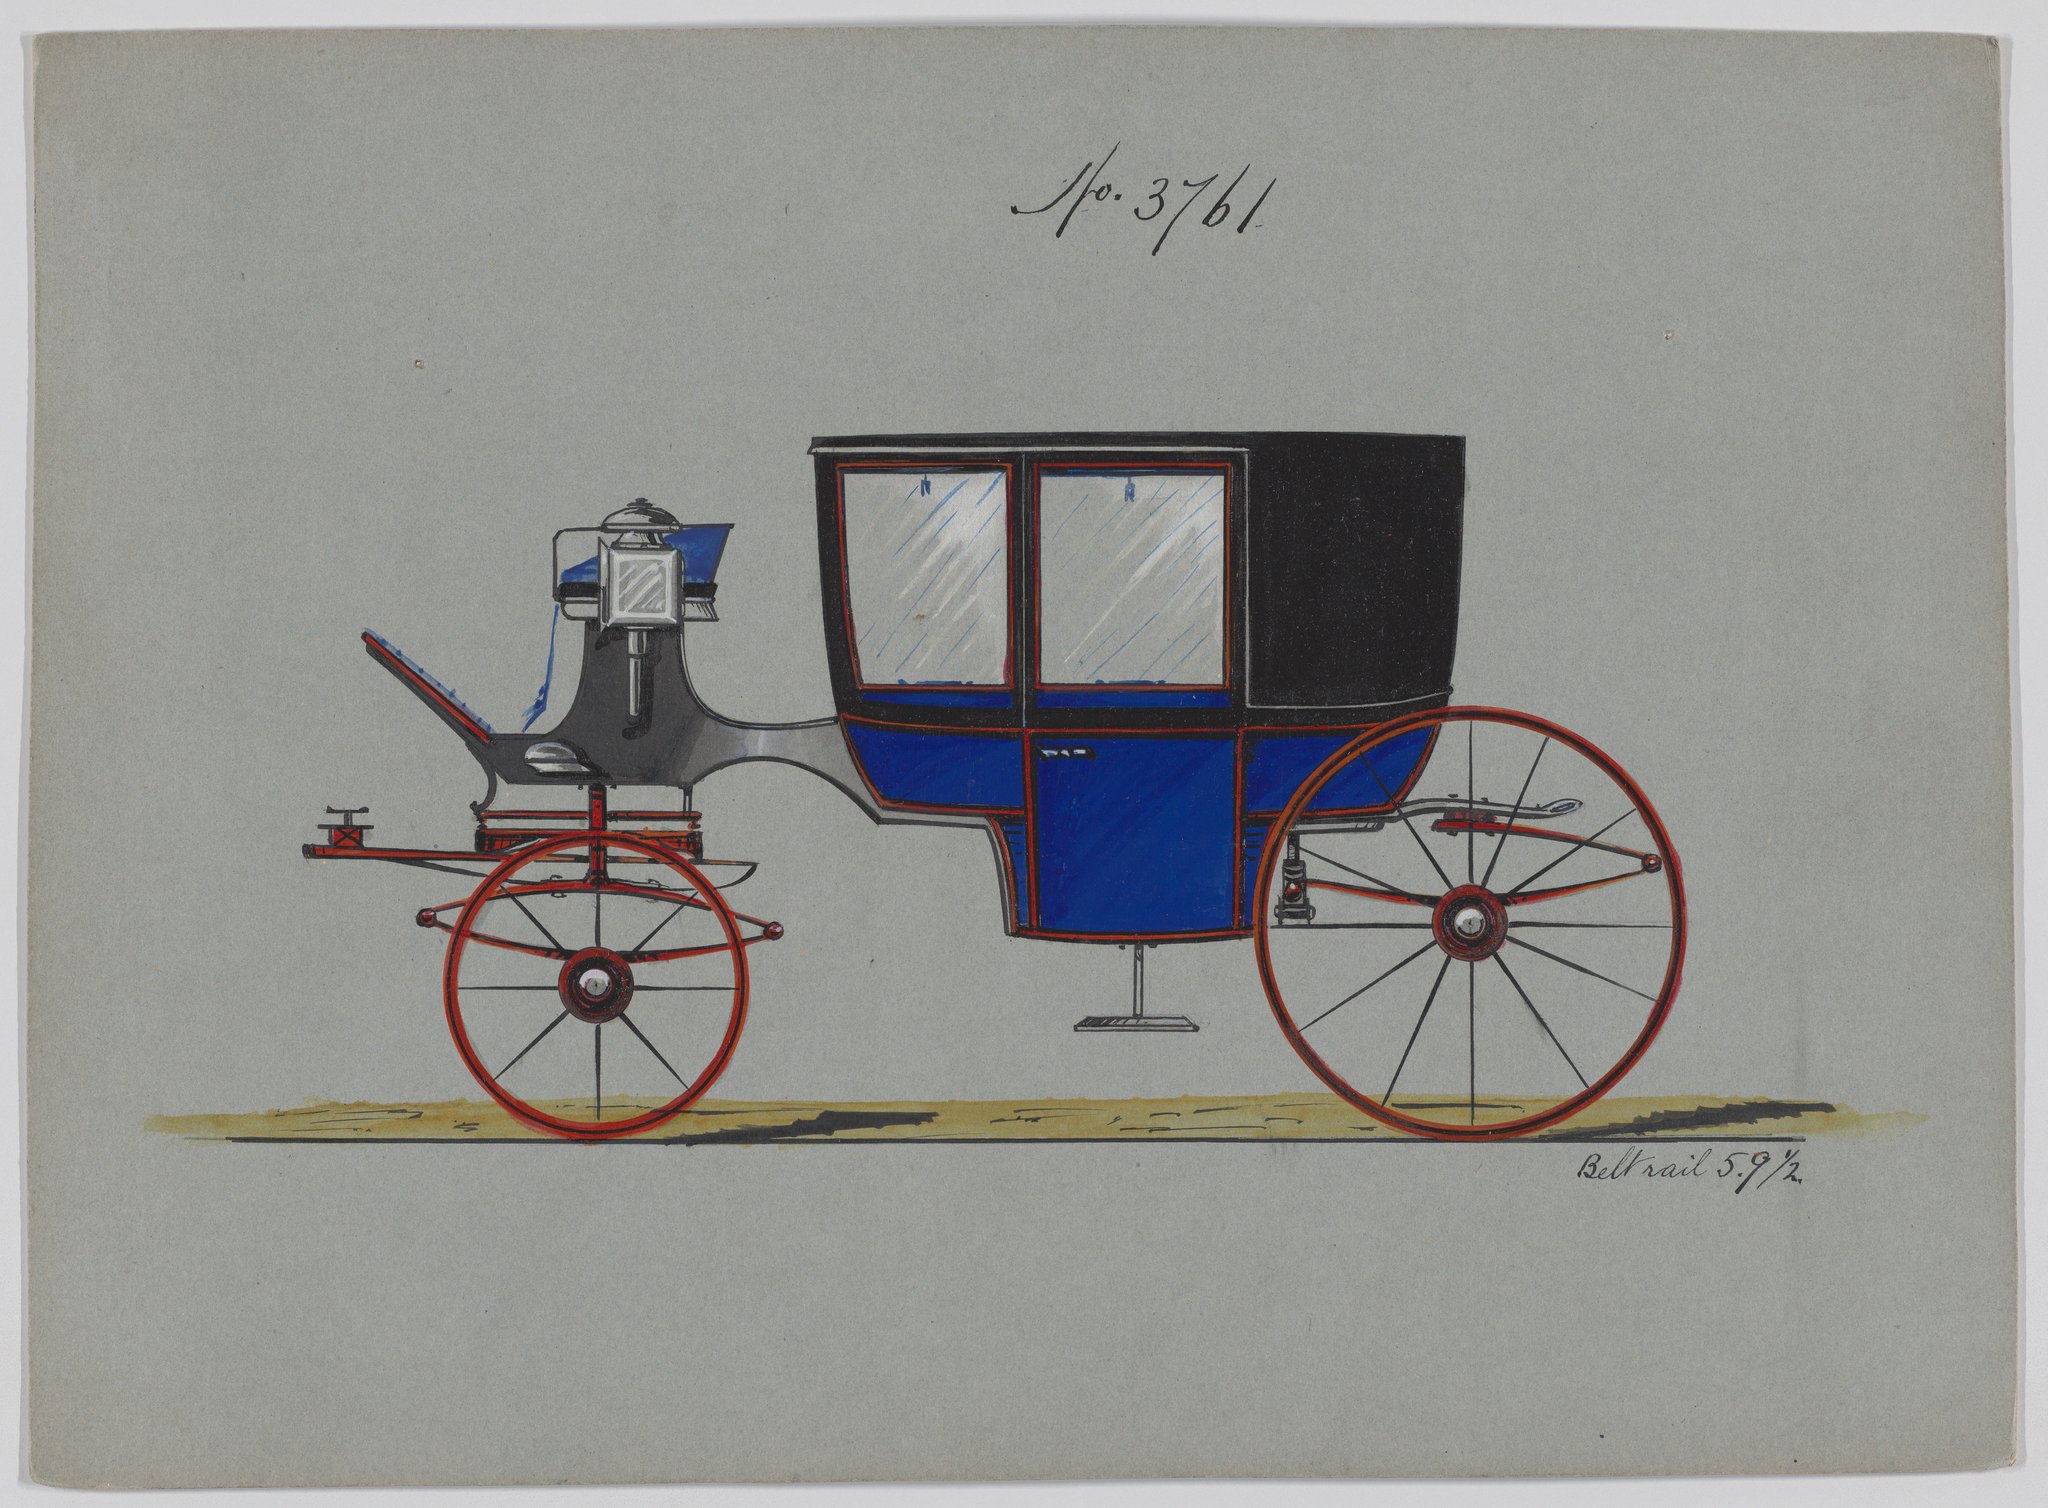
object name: drawing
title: Coach #3761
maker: brewster & co.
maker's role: manufacturer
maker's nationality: american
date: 1882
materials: gouache, gum arabic, ink, watercolor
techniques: pen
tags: carriages